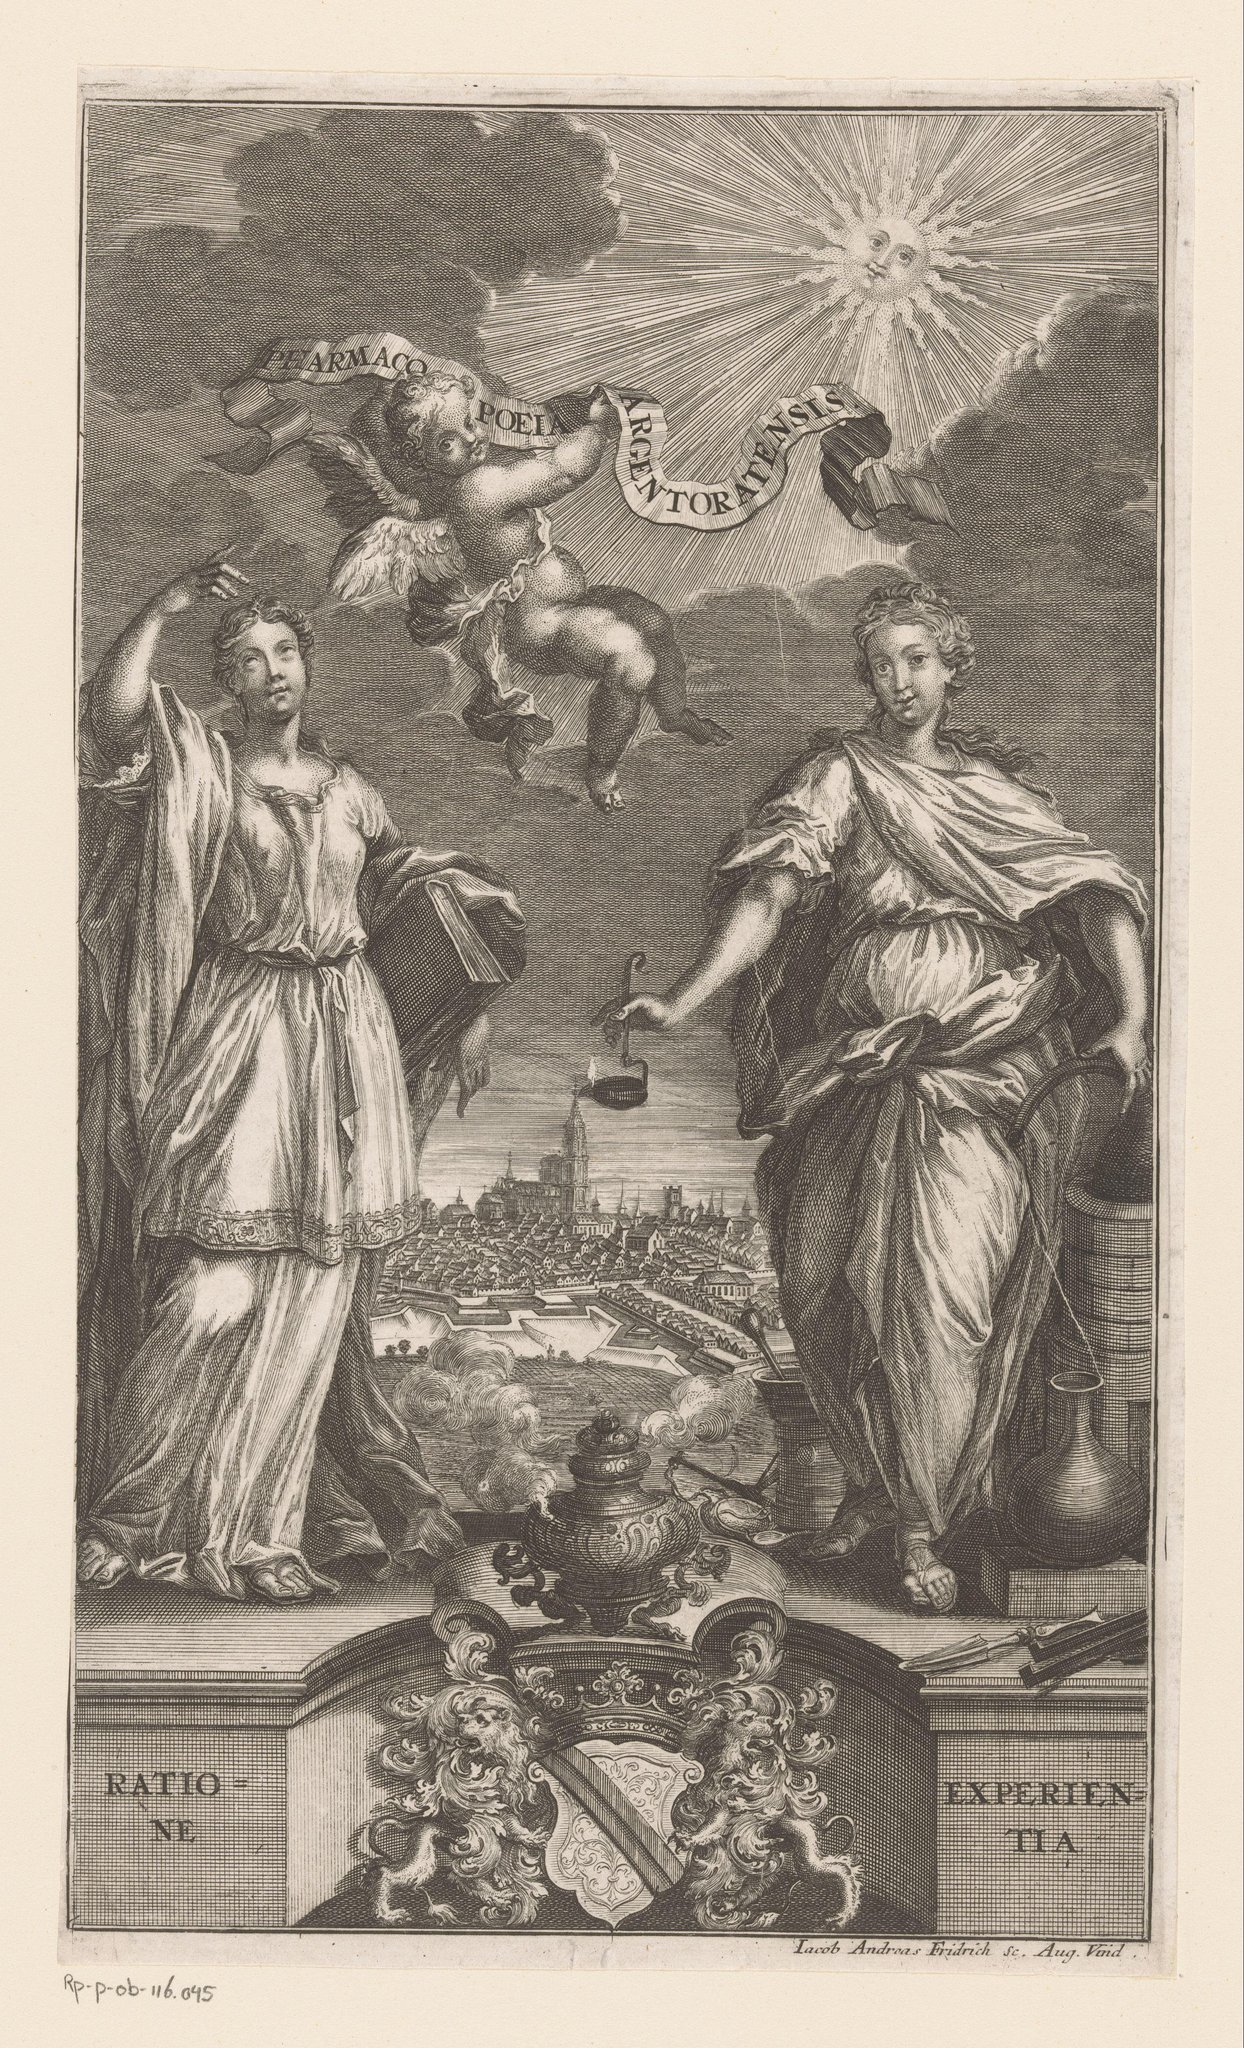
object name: print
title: Pharmacopoeia Argentoratensis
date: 1725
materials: paper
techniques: engraving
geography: straatsburg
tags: city-view in general; 'veduta', research, experiment (~ production), sun as celestial body, medicine, medical science, tools and implements of pharmacist, cupids: 'amores', 'amoretti', 'putti', armorial bearing, heraldry, reason; 'ragione' (ripa) (+ abstract concept represented by female figure)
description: Prent uit: Pharmacopoeia Argentoratensis (...) a Collegio Medico adornata. Straatsburg: Johann Reinhold Dulssecker, 1725.